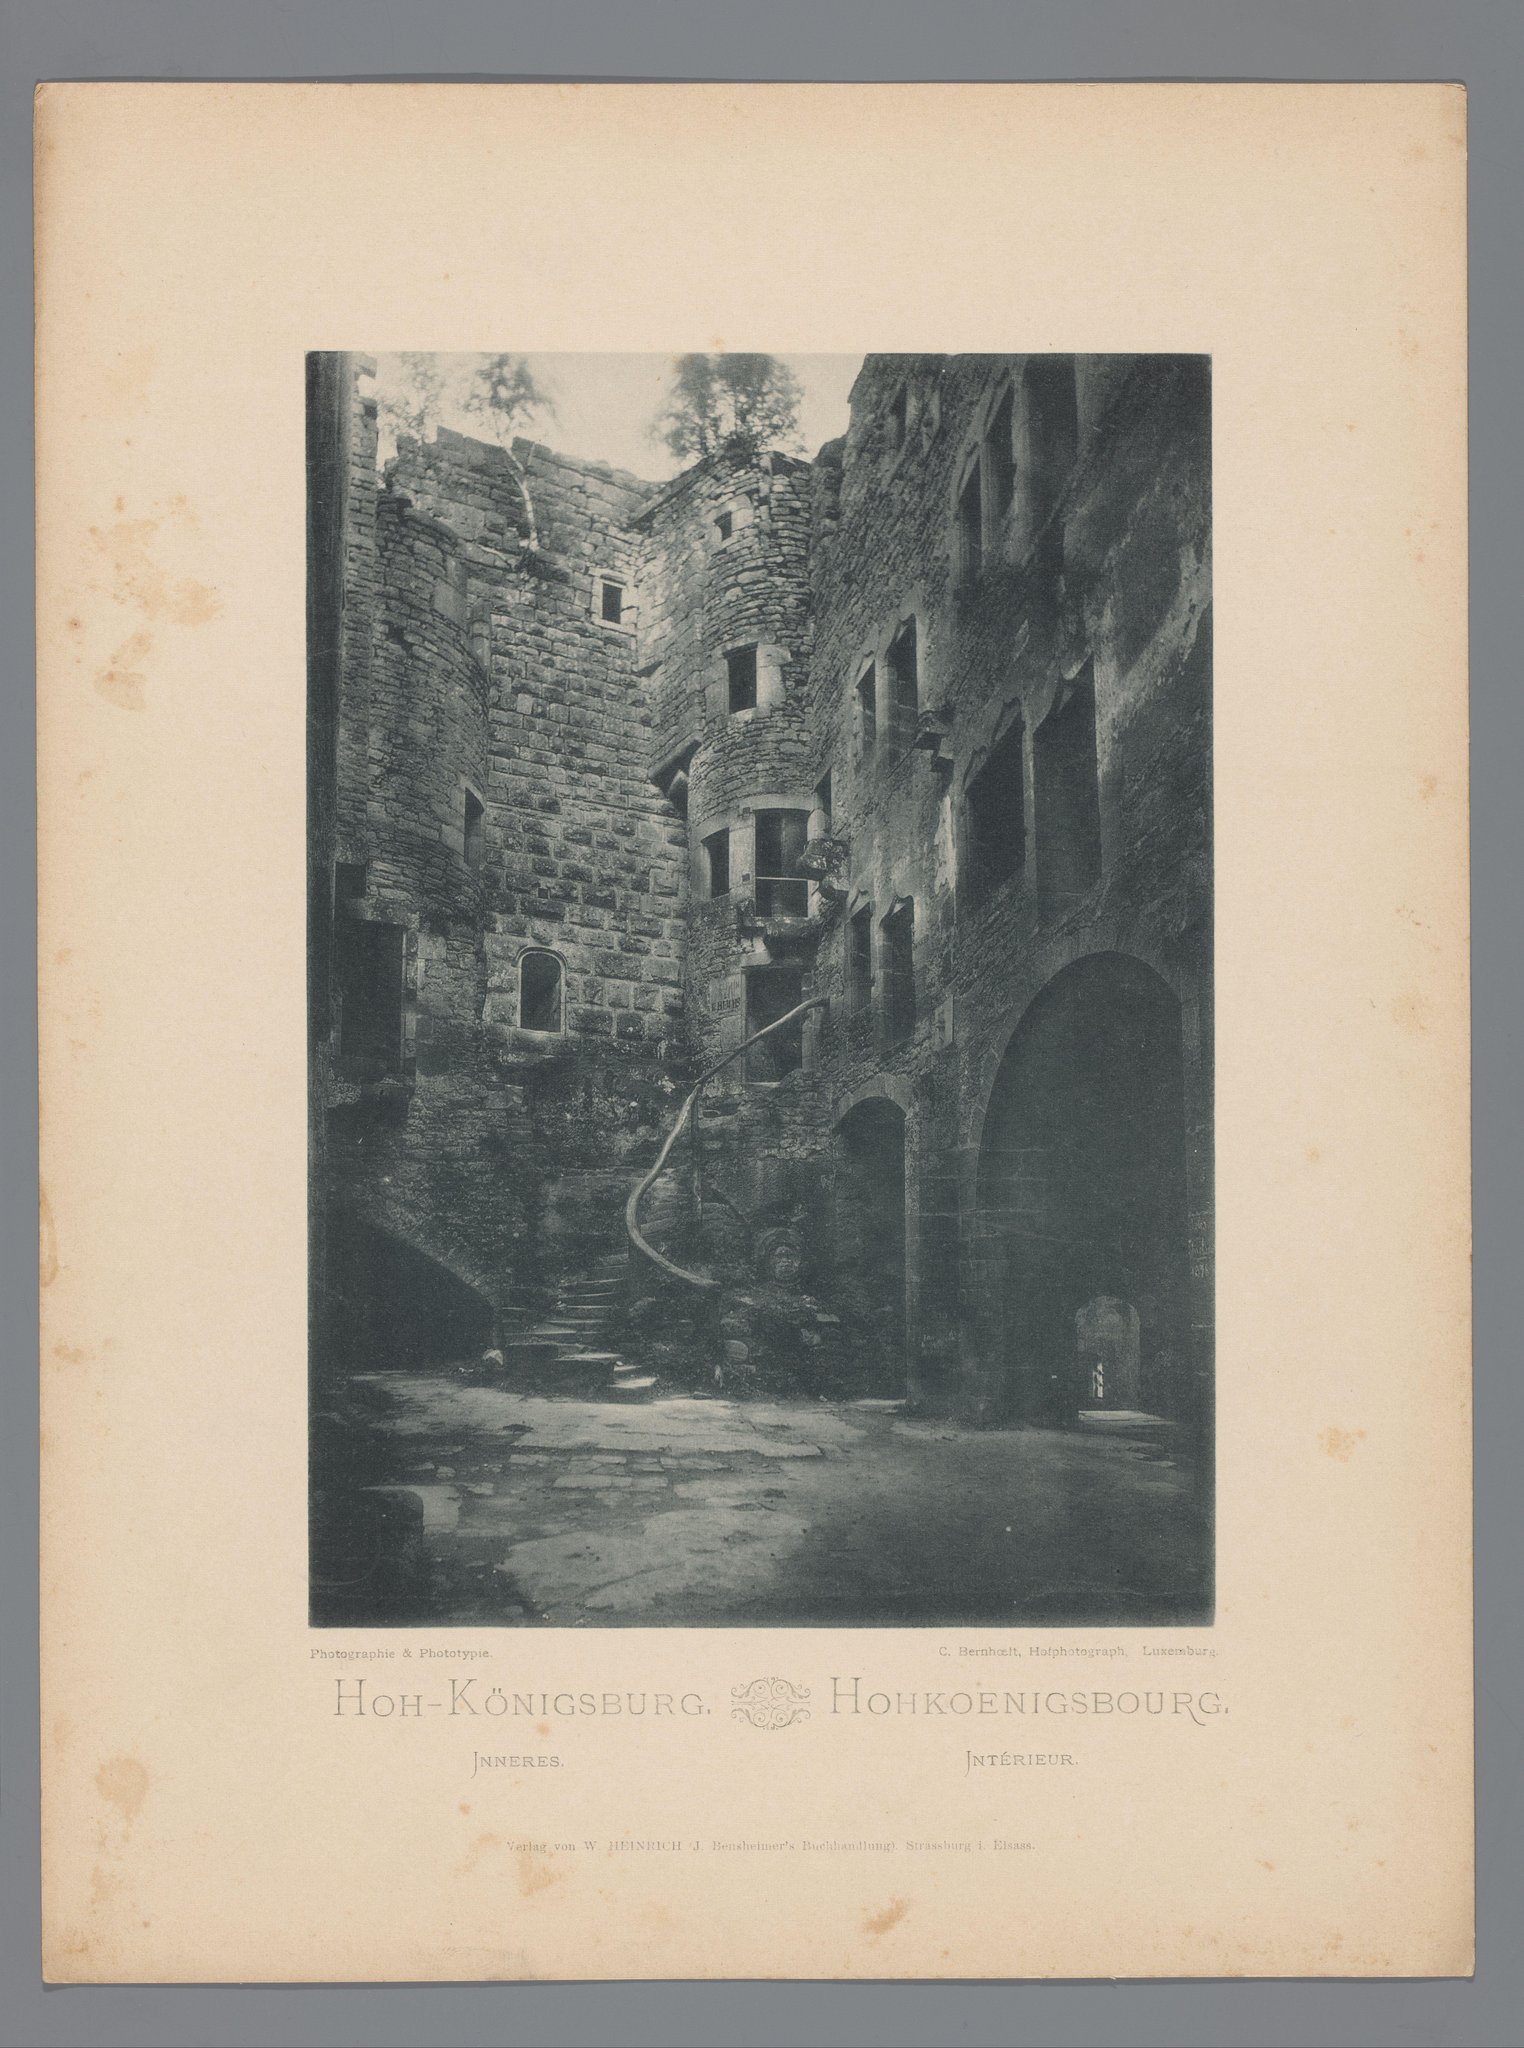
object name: page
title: Interieur van het Kasteel Haut-Koenigsbourg te Orschwiller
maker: charles bernhoeft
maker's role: publisher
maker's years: 1859-1933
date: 1889-1894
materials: paper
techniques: photograph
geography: straatsburg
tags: castle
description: Deze prent maakt deel uit van een omslag met 100 prenten.